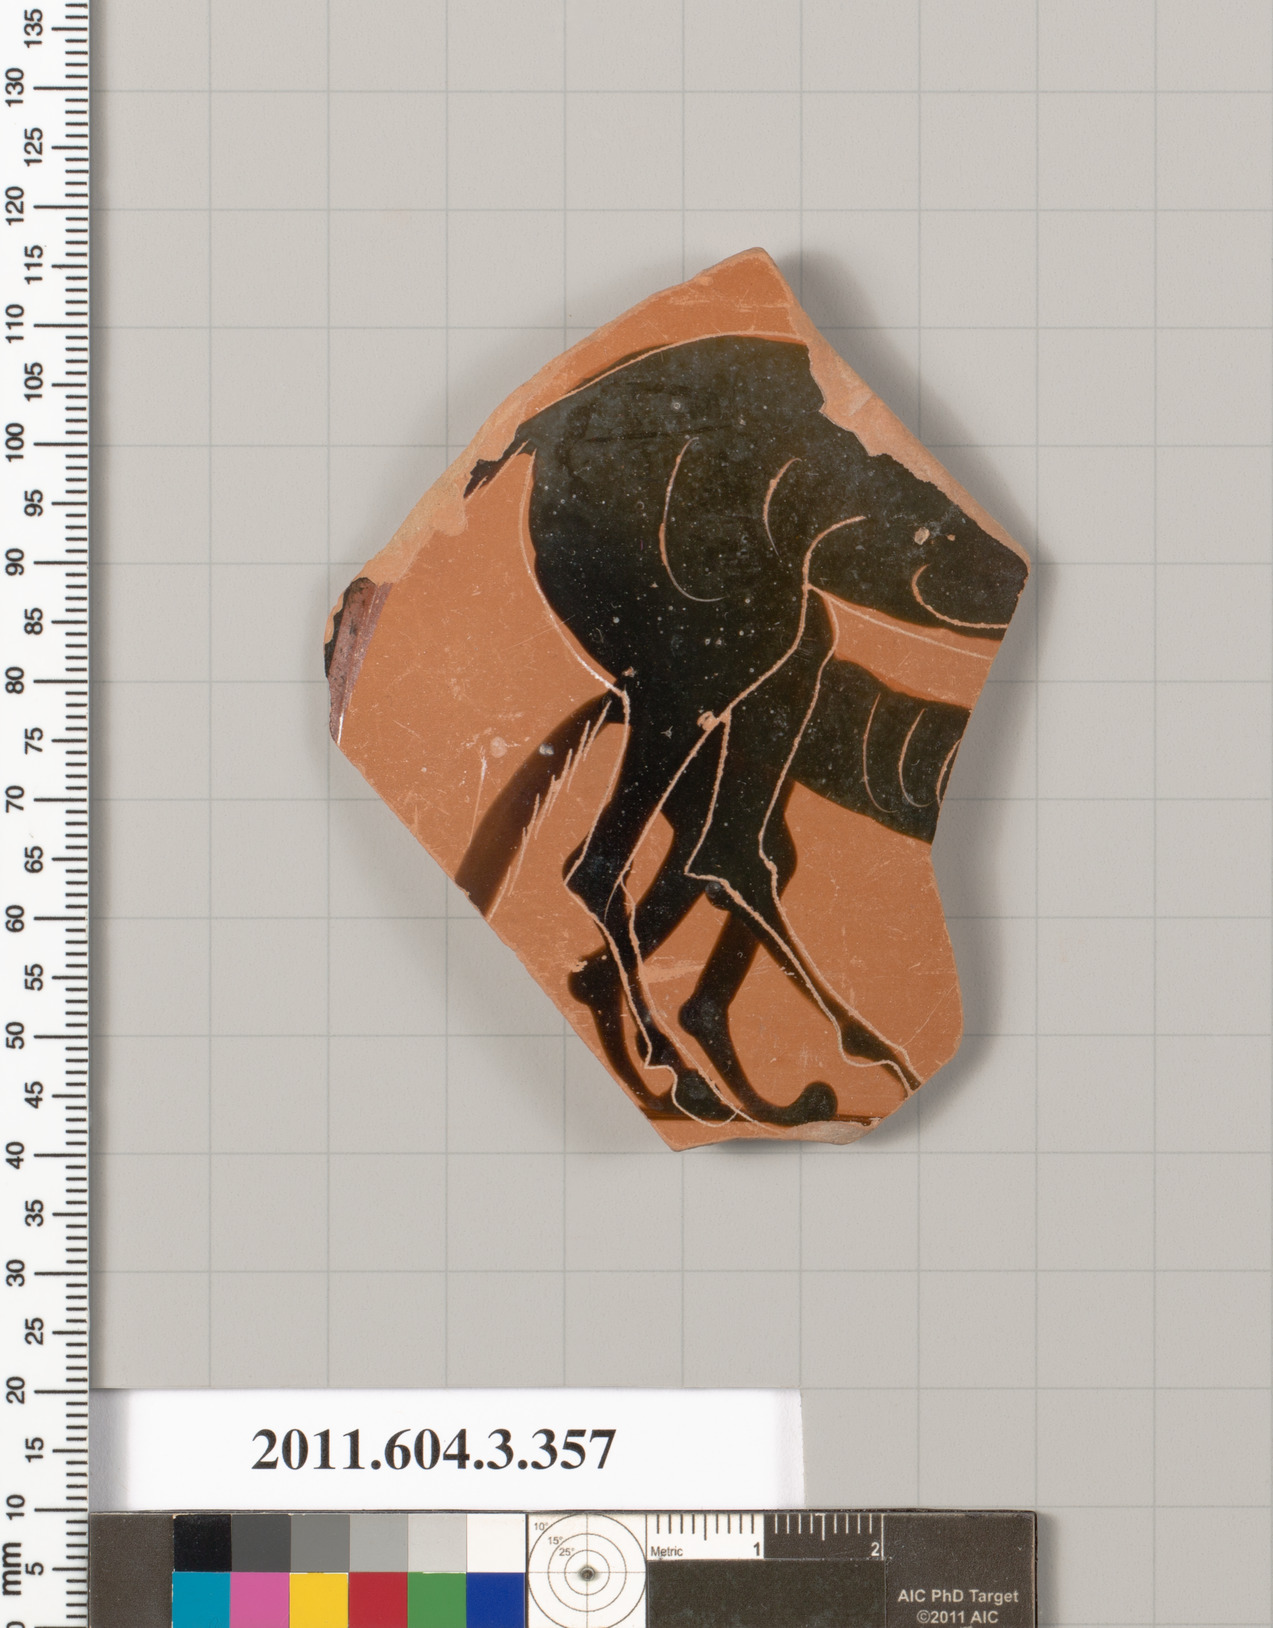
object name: neck amphora fragment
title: Terracotta fragment of a neck-amphora (jar)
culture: greek, attic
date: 525-501 BCE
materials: terracotta